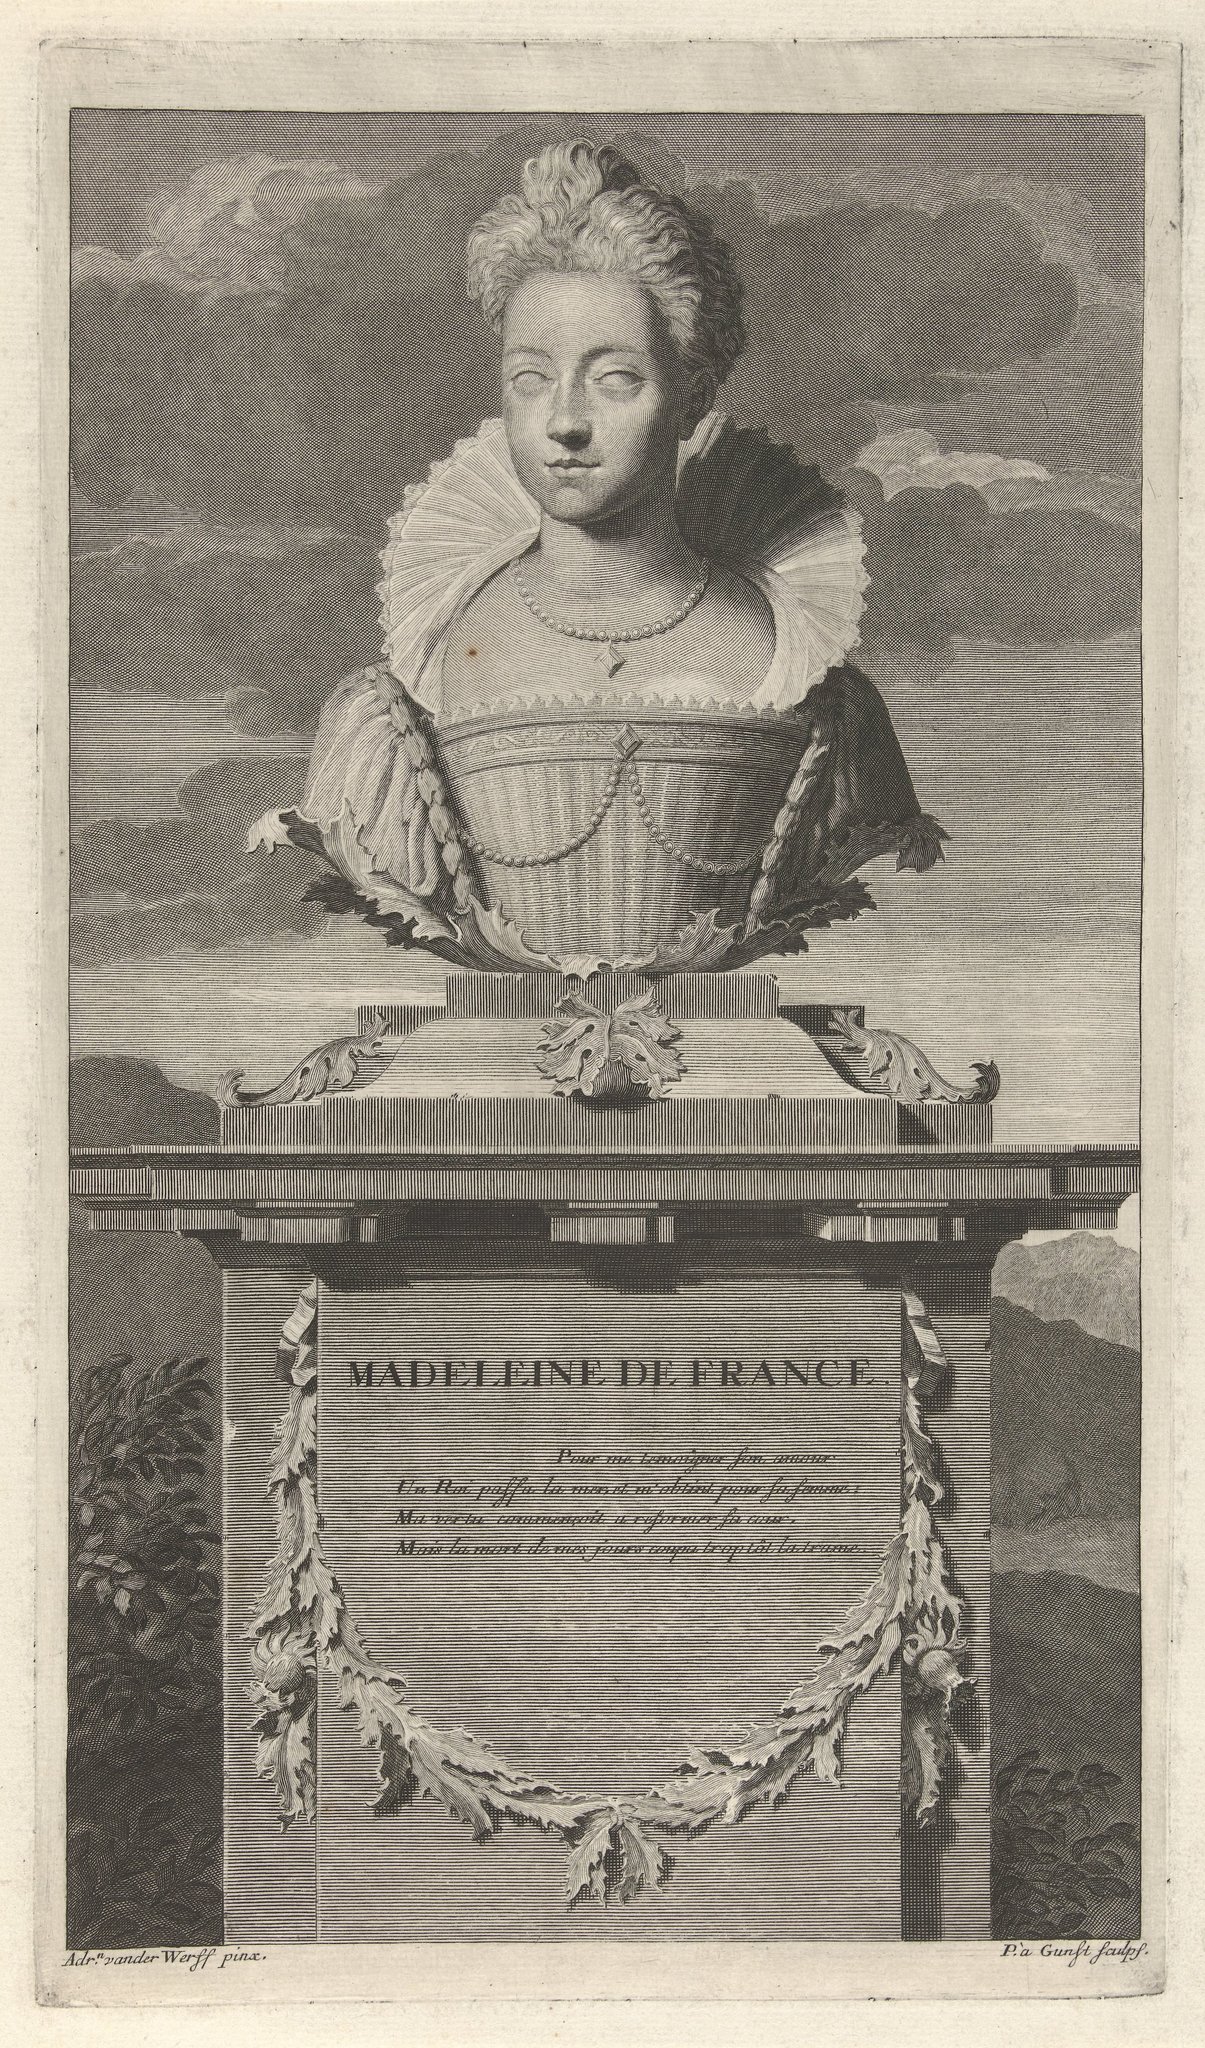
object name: print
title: Buste van Magdalena van Valois, koningin van Schotland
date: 1669-1731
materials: paper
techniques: engraving, etching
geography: amsterdam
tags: saint-germain-en-laye, edinburgh, koningin, magdalena van valois (koningin van schotland)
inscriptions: collector's mark: Lugt 240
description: Standbeeldbuste van Magdalena van Valois, koningin van Schotland die op zestienjarige leeftijd stierf. Het beeld staat op een voetstuk met een Frans gedicht over haar leven.